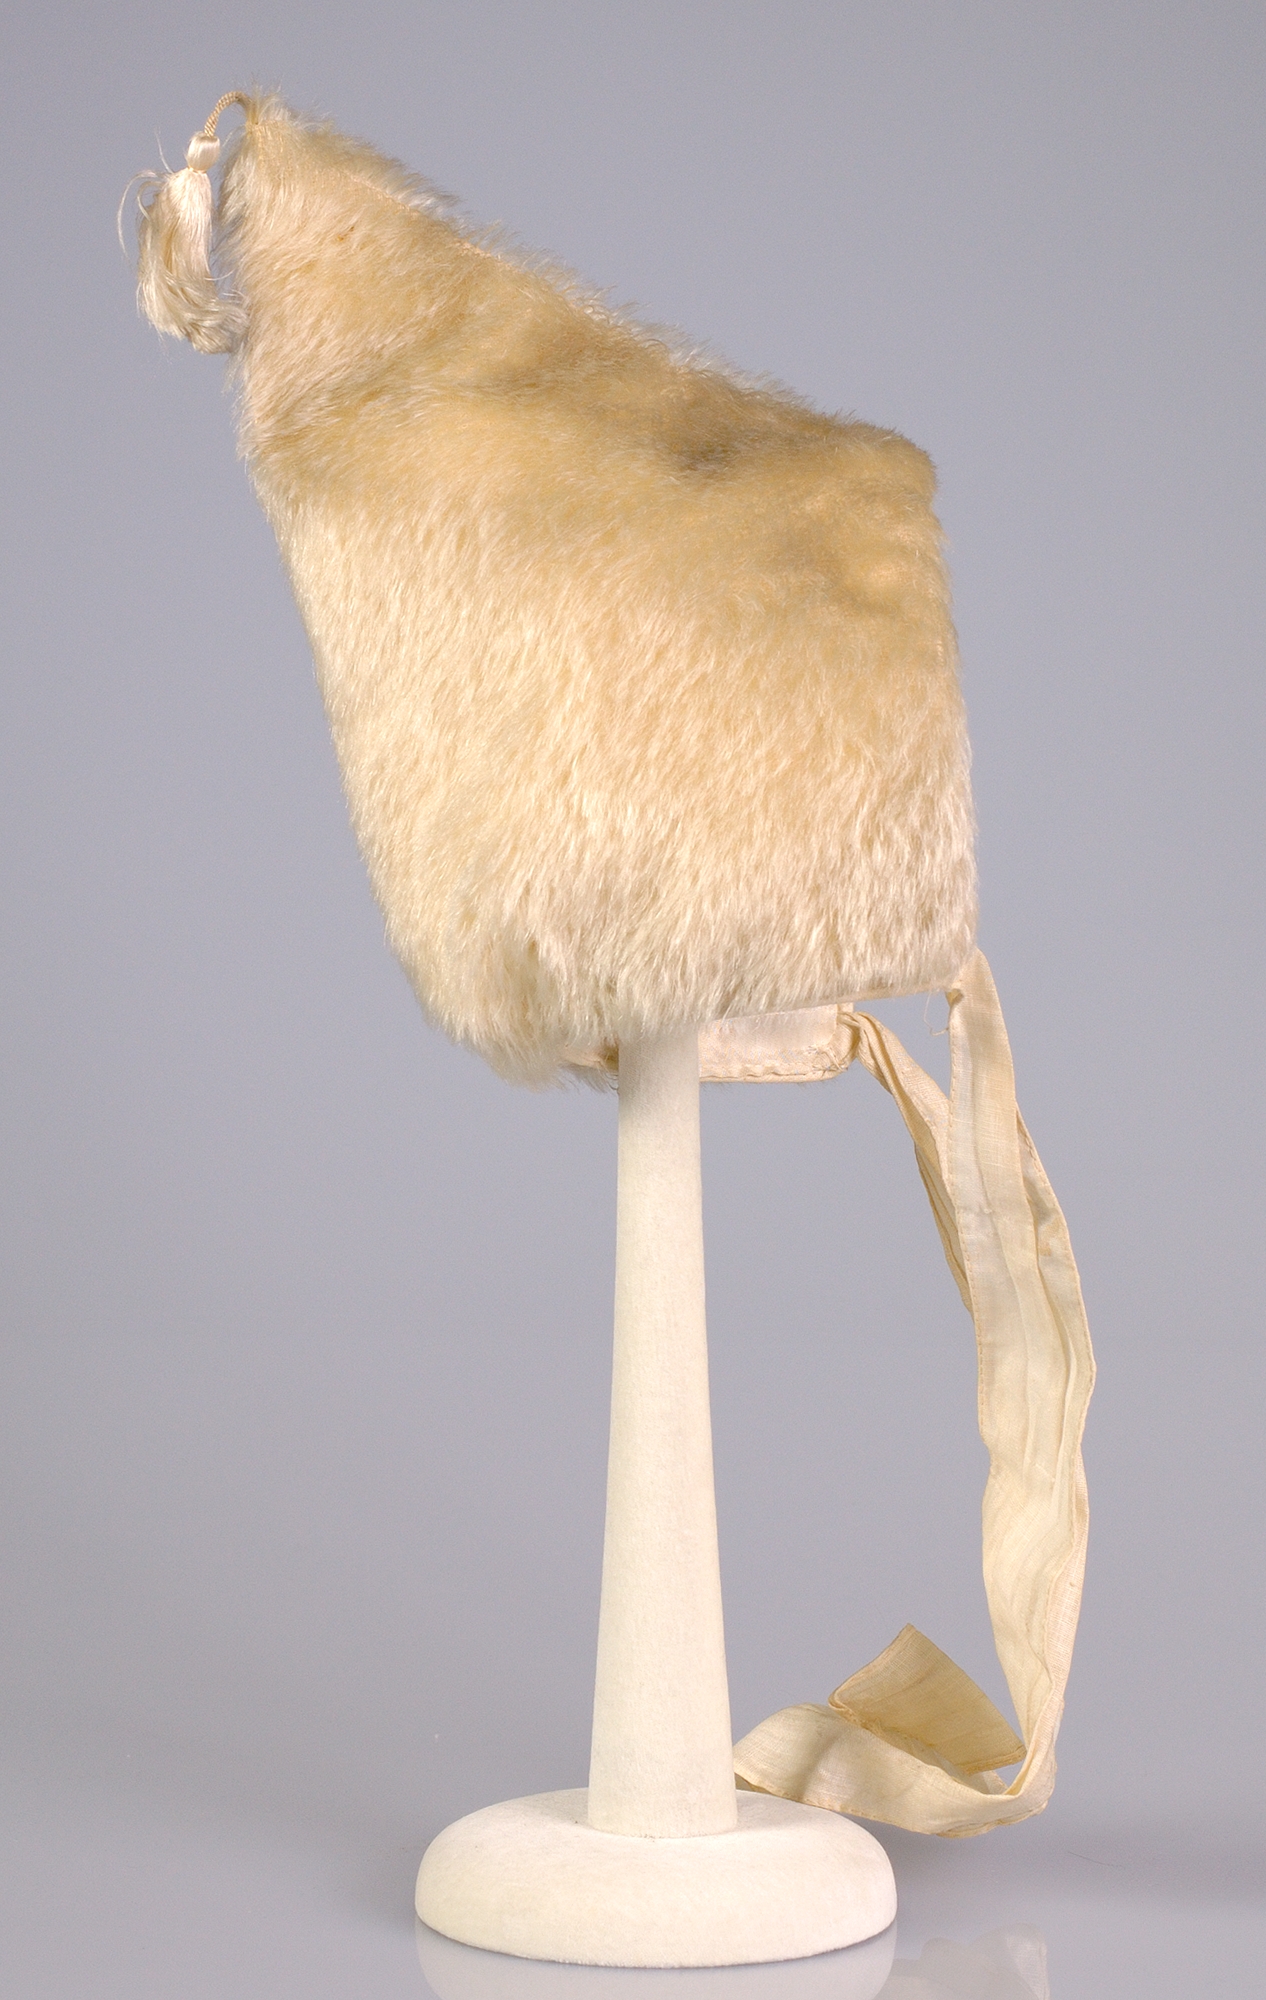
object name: cap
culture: american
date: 1895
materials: cotton, silk, wool